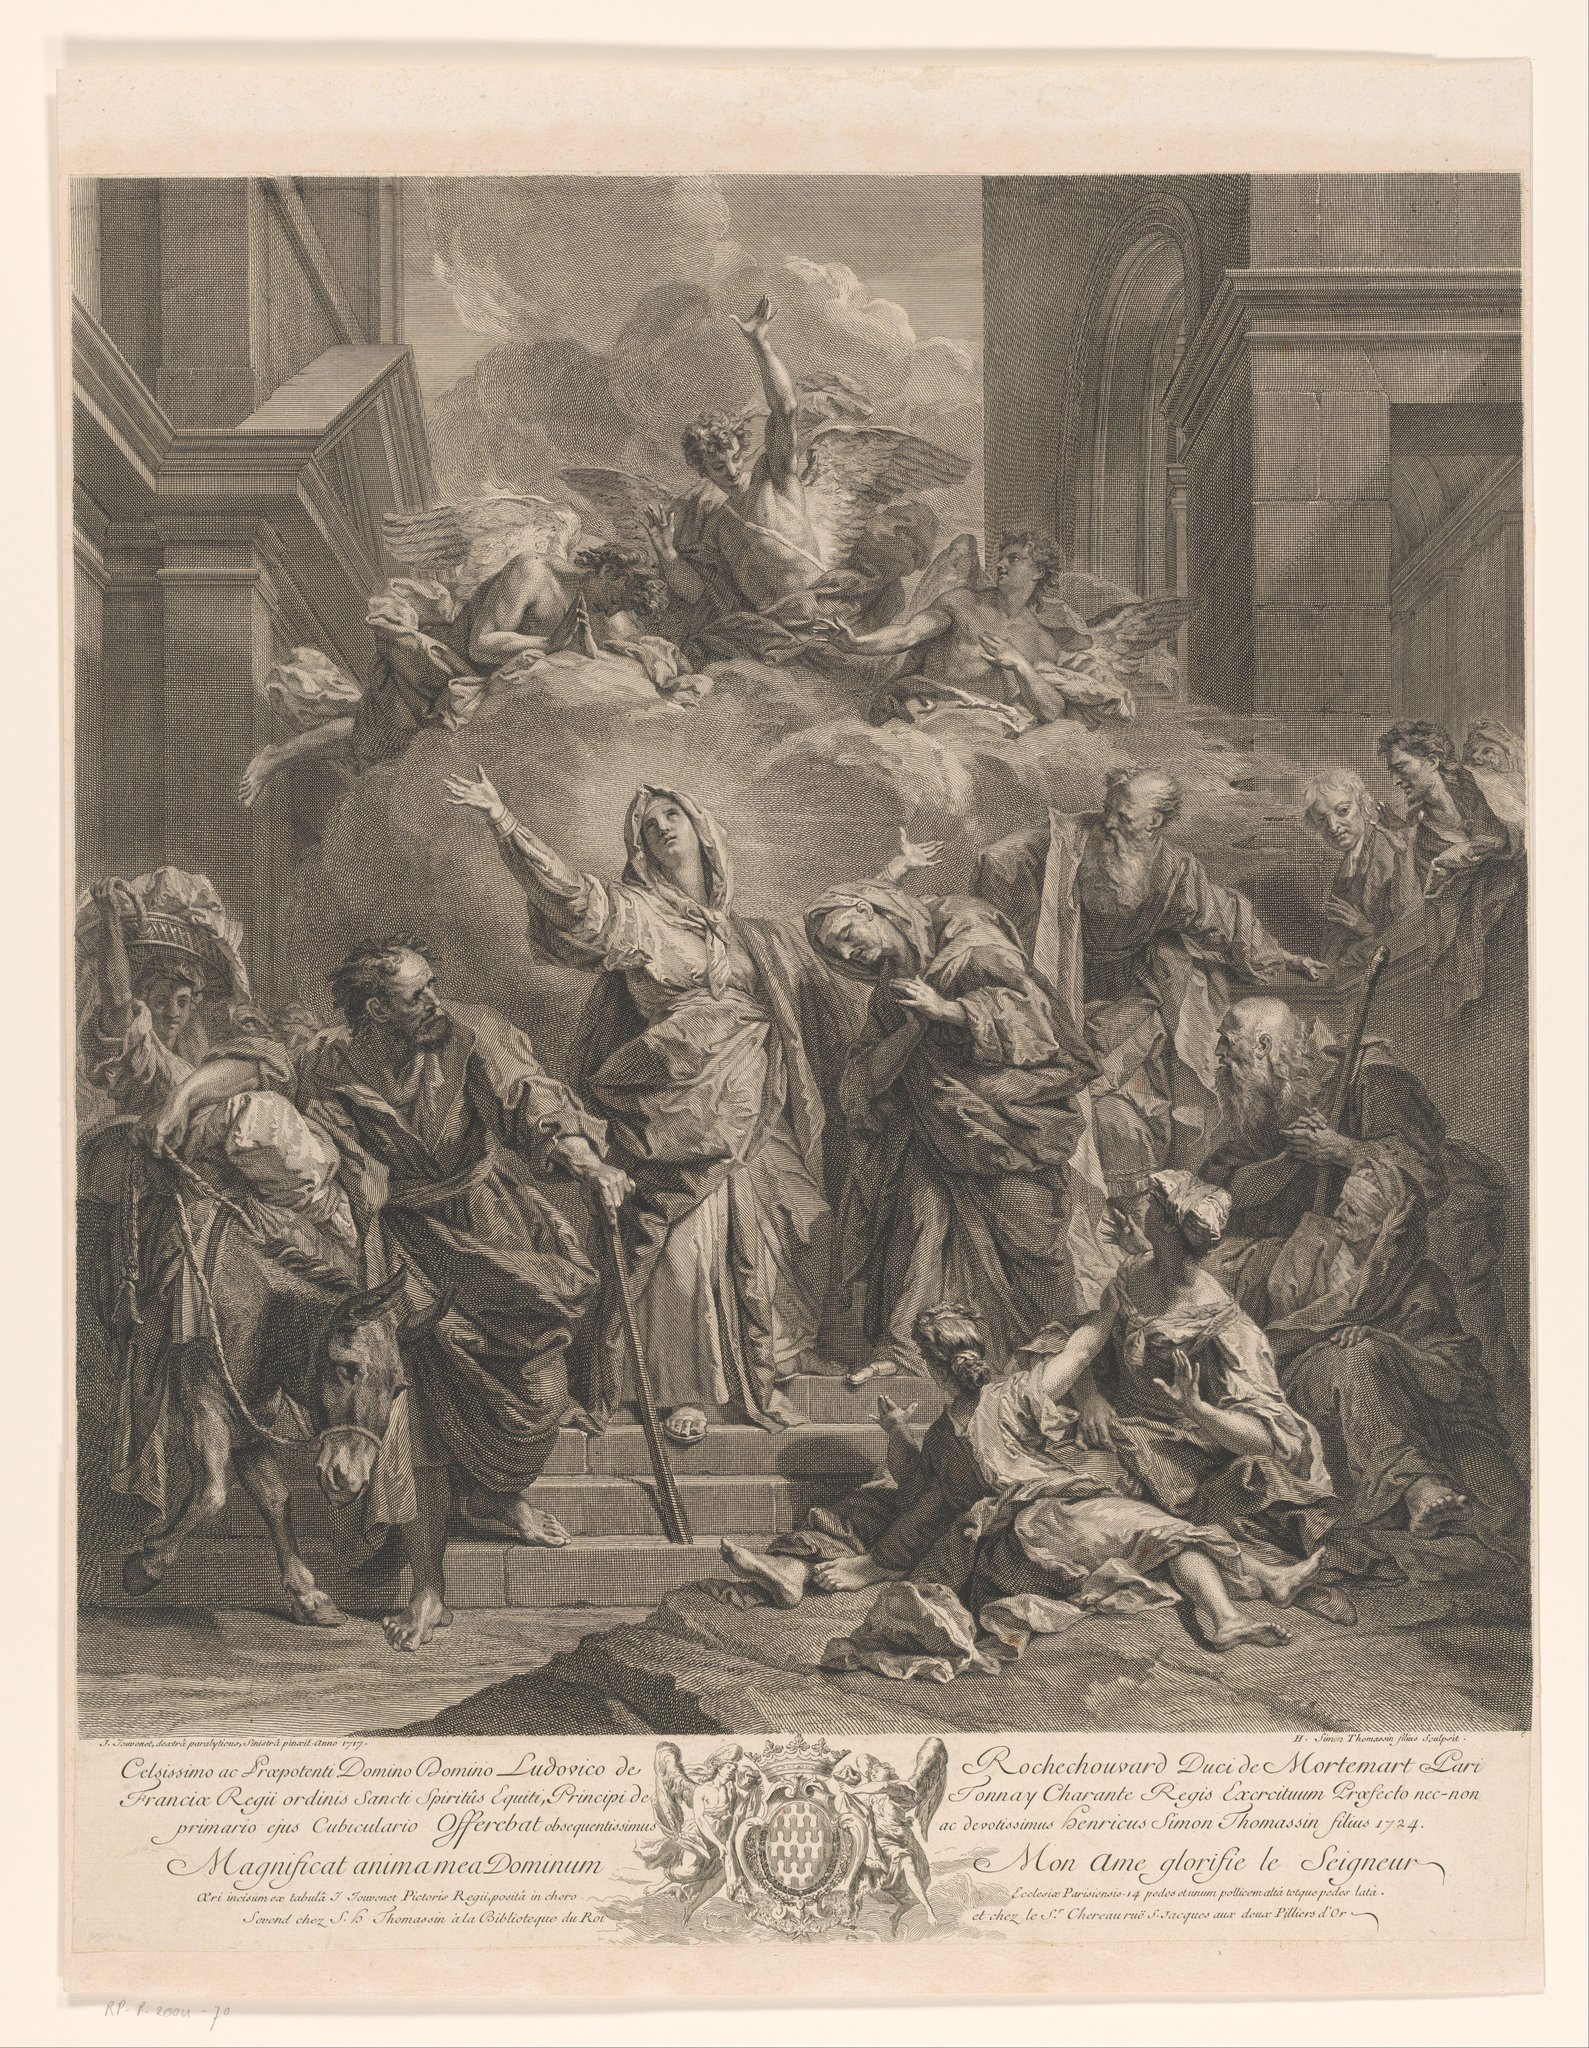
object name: print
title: Magnificat anima mea Dominum (mijn ziel prijst de heer)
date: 1724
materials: paper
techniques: engraving, etching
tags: mary magnifying the lord ('magnificat')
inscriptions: collector's mark: Lugt 2228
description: Maria staat op een trede voor een tempel, de armen opgeheven. Boven haar hoofd een stralenkrans en engelen in een wolk. Met omstanders.